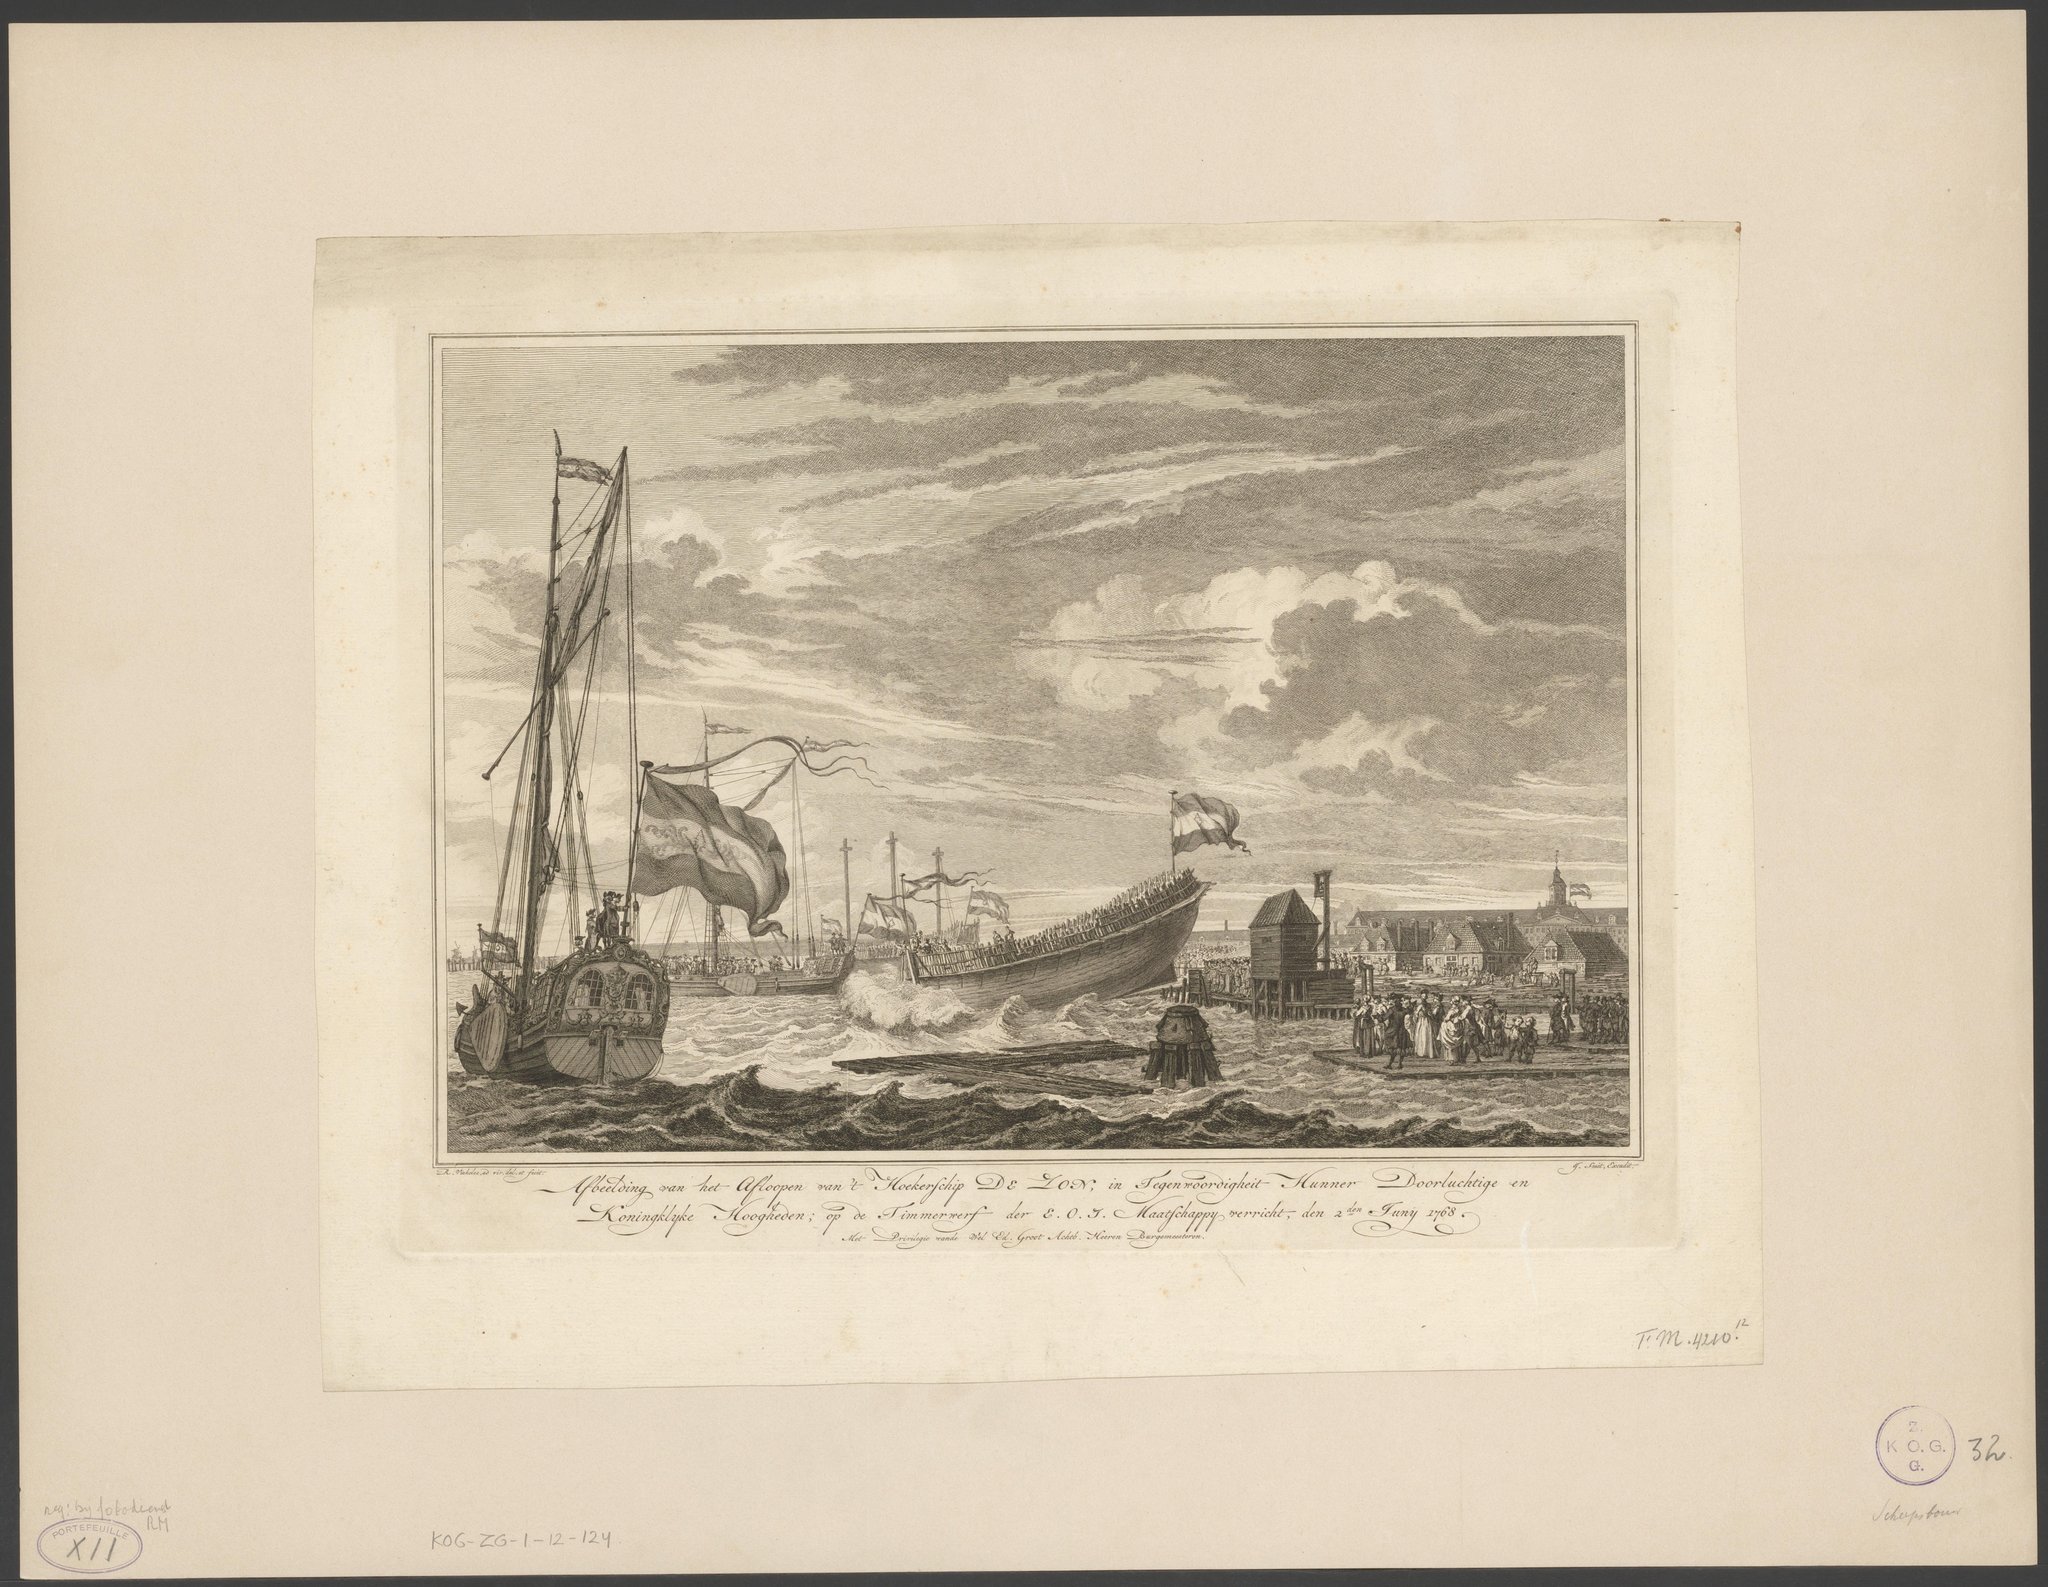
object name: print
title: Afbeelding der Vreugdebedryven en Plegtigheden die by de aankomst en gedurende het verblyf (...) Willem (...) en zyne Gemaalinne (...) zyn voorgevallen te Amsterdam, op maandag, den 30 Mey, en eenige volgende dagen, des jaars 1768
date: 1768-1787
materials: paper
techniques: engraving, etching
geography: amsterdam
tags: the hague, william v (prince of orange), berlin, painter, draughtsman, wilhelmina of prussia (princess of orange), public festivities on the occasion of royal events, launching a ship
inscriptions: stamp, collector's mark: Lugt 1641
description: De tewaterlating of het aflopen van het hoekerschip De Zon voor de VOC op de scheepstimmerwerf bij het Oostindisch Zeemagazijn te Amsterdam, in tegenwoordigheid van stadhouder Willem V en prinses Wilhelmina van Pruisen, 2 juni 1768. Onderwerpsrubrieken binnen de Atlas Zeden en Gewoonten: Handel, Nijverheid en Verkeer, Scheepsvaart.